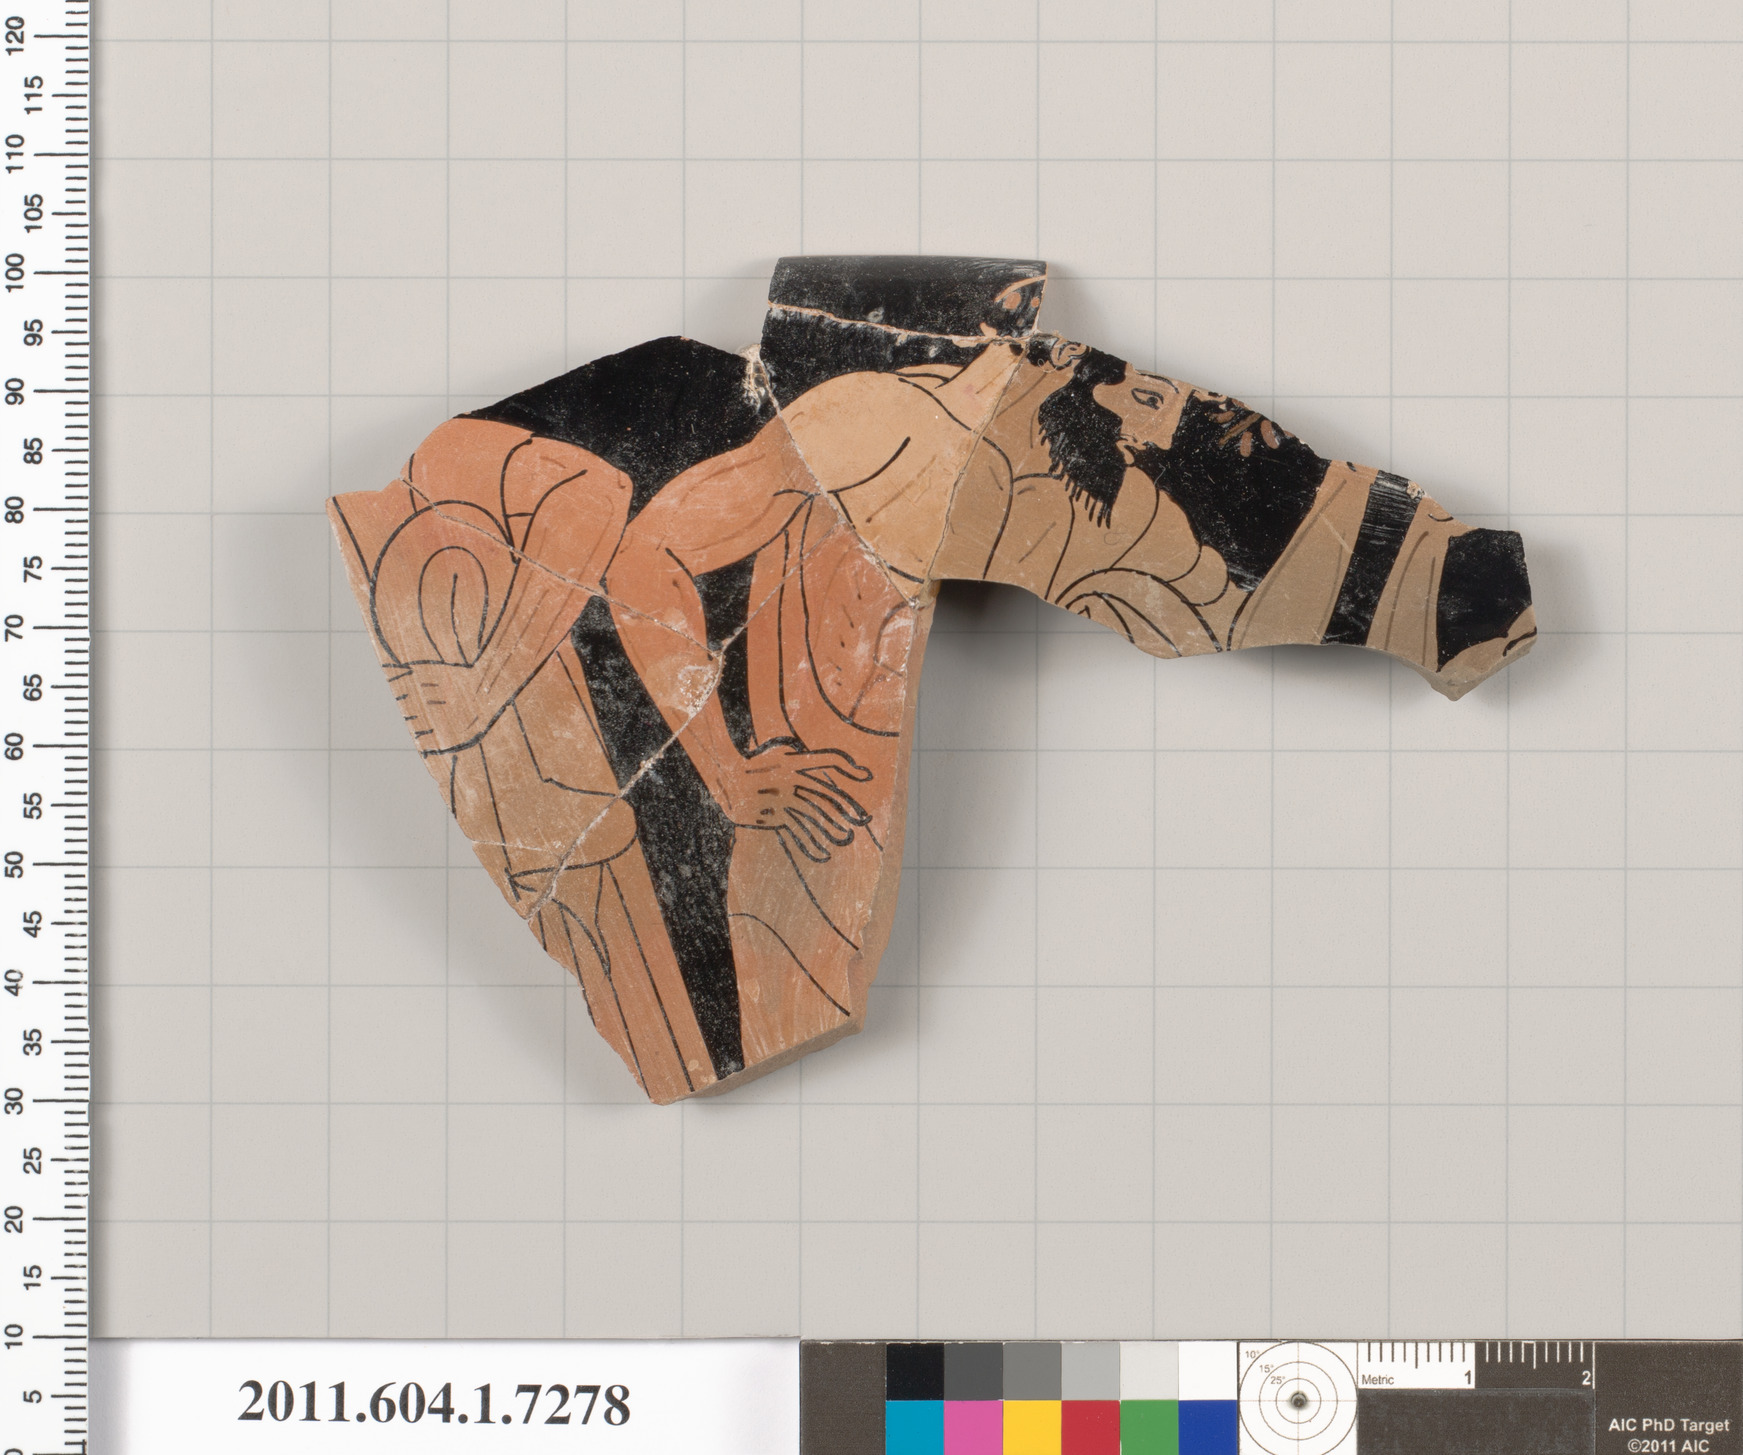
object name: kylix fragment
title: Terracotta rim fragment of a kylix (drinking cup)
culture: greek, attic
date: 500-480 BCE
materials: terracotta